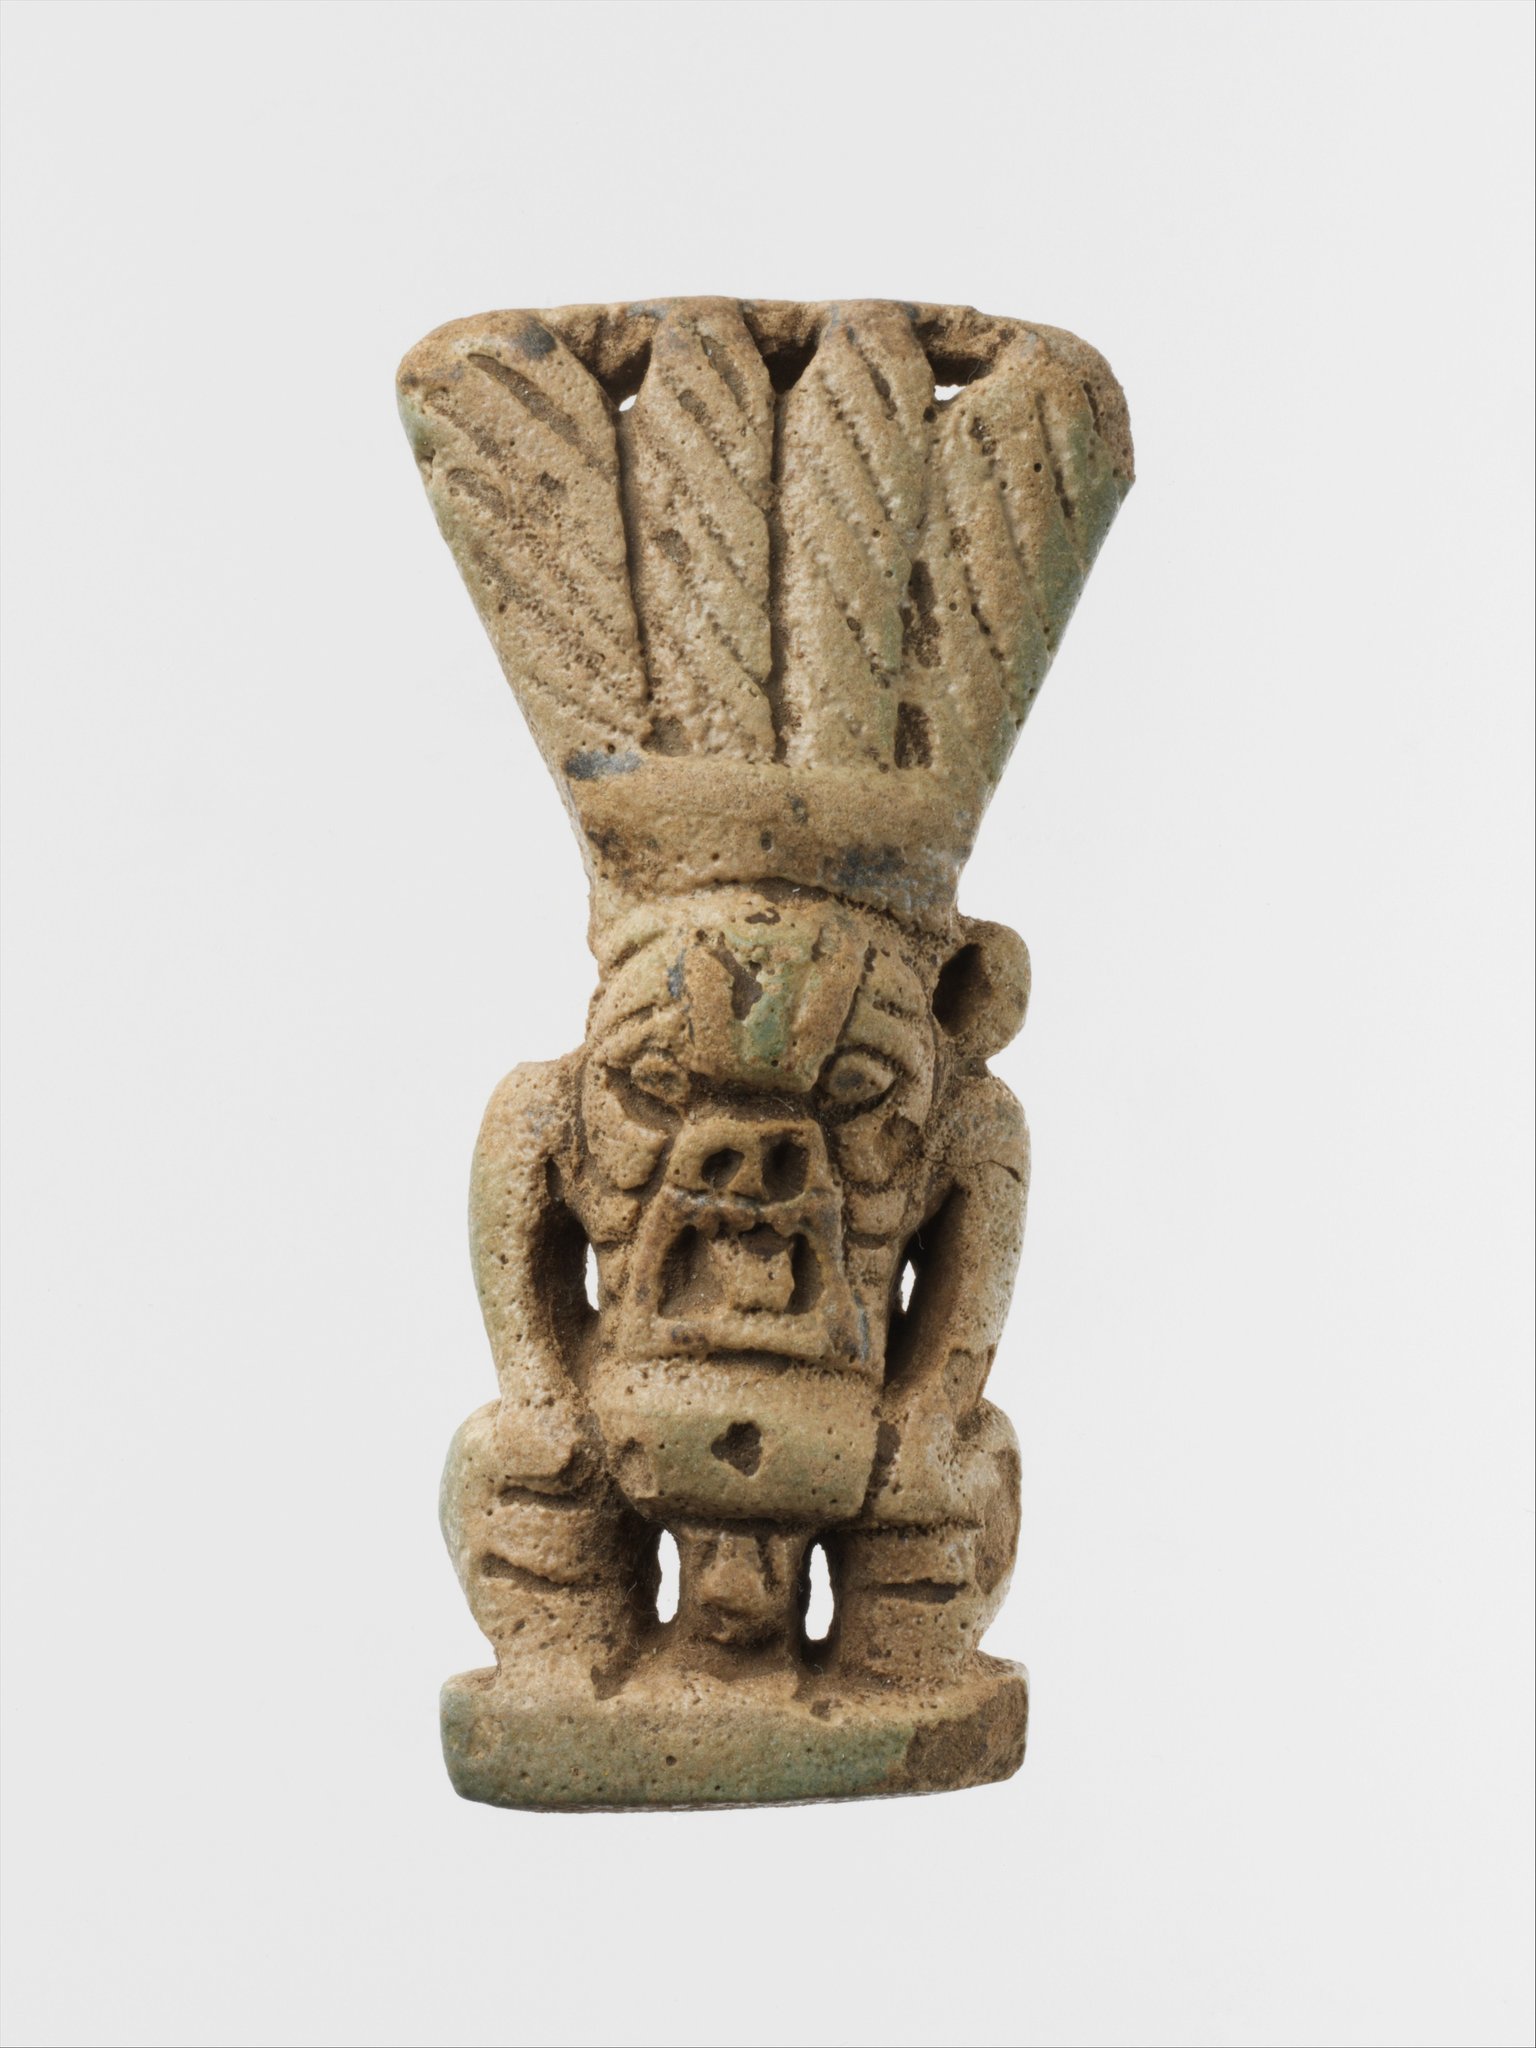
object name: amulet, be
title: Faience amulet of Bes image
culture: egyptian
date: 1090-900 BCE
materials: faience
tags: bes